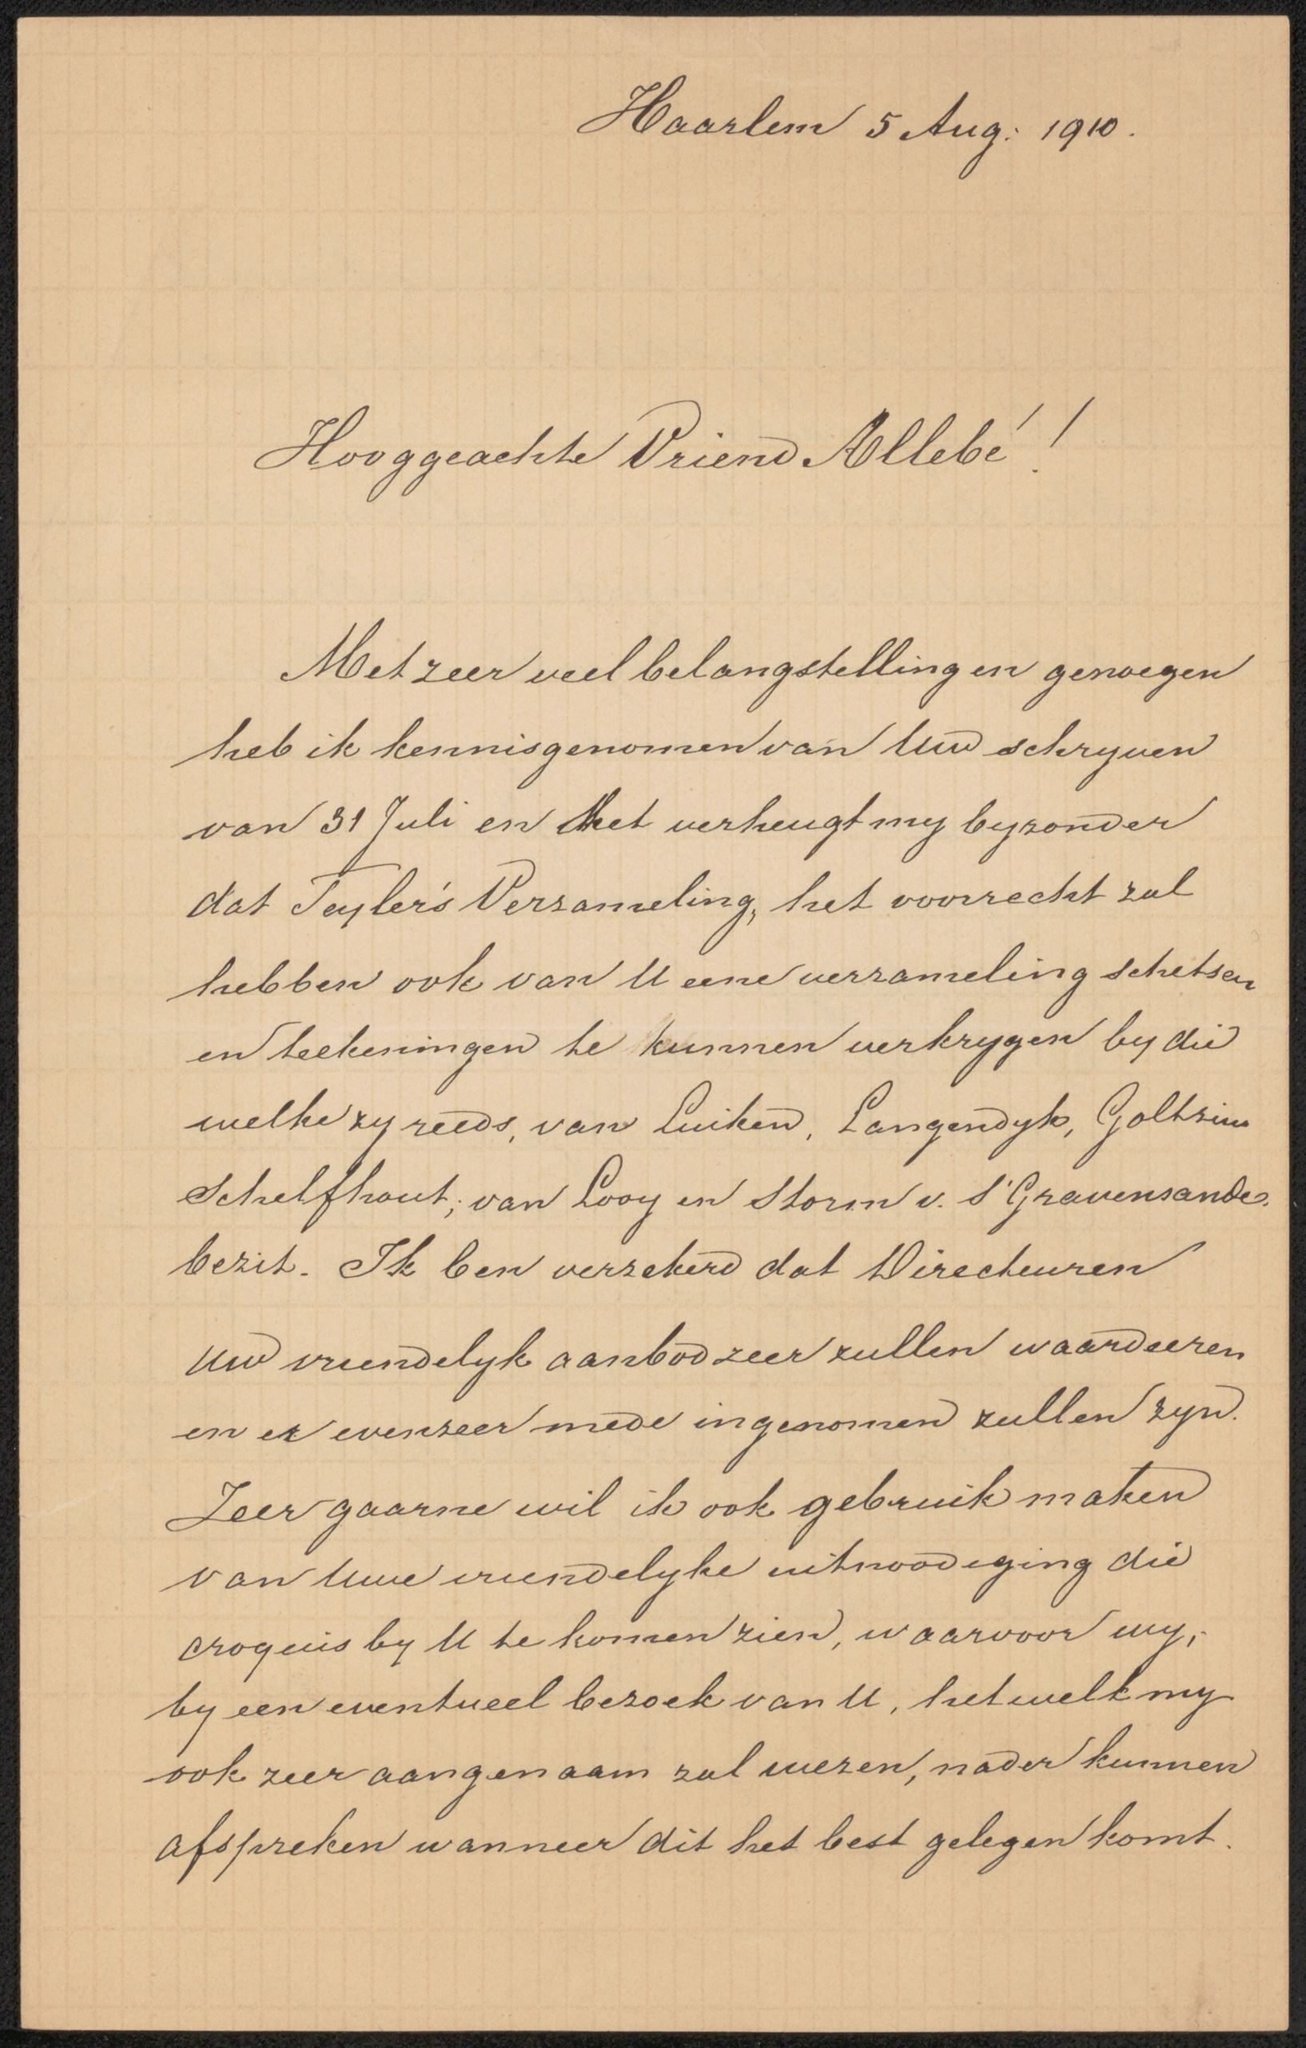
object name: letter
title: Brief aan August Allebé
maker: hendrik jacobus scholten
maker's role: draughtsman, painter, print maker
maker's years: 1824-1907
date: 1910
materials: ink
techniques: pen, writing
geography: haarlem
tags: painter, gerrit pieter verschuur, amsterdam, print maker, draughtsman, august allebé, wouter verschuur (1841-1936), drawing, family life, diseases, art collecting, haarlem